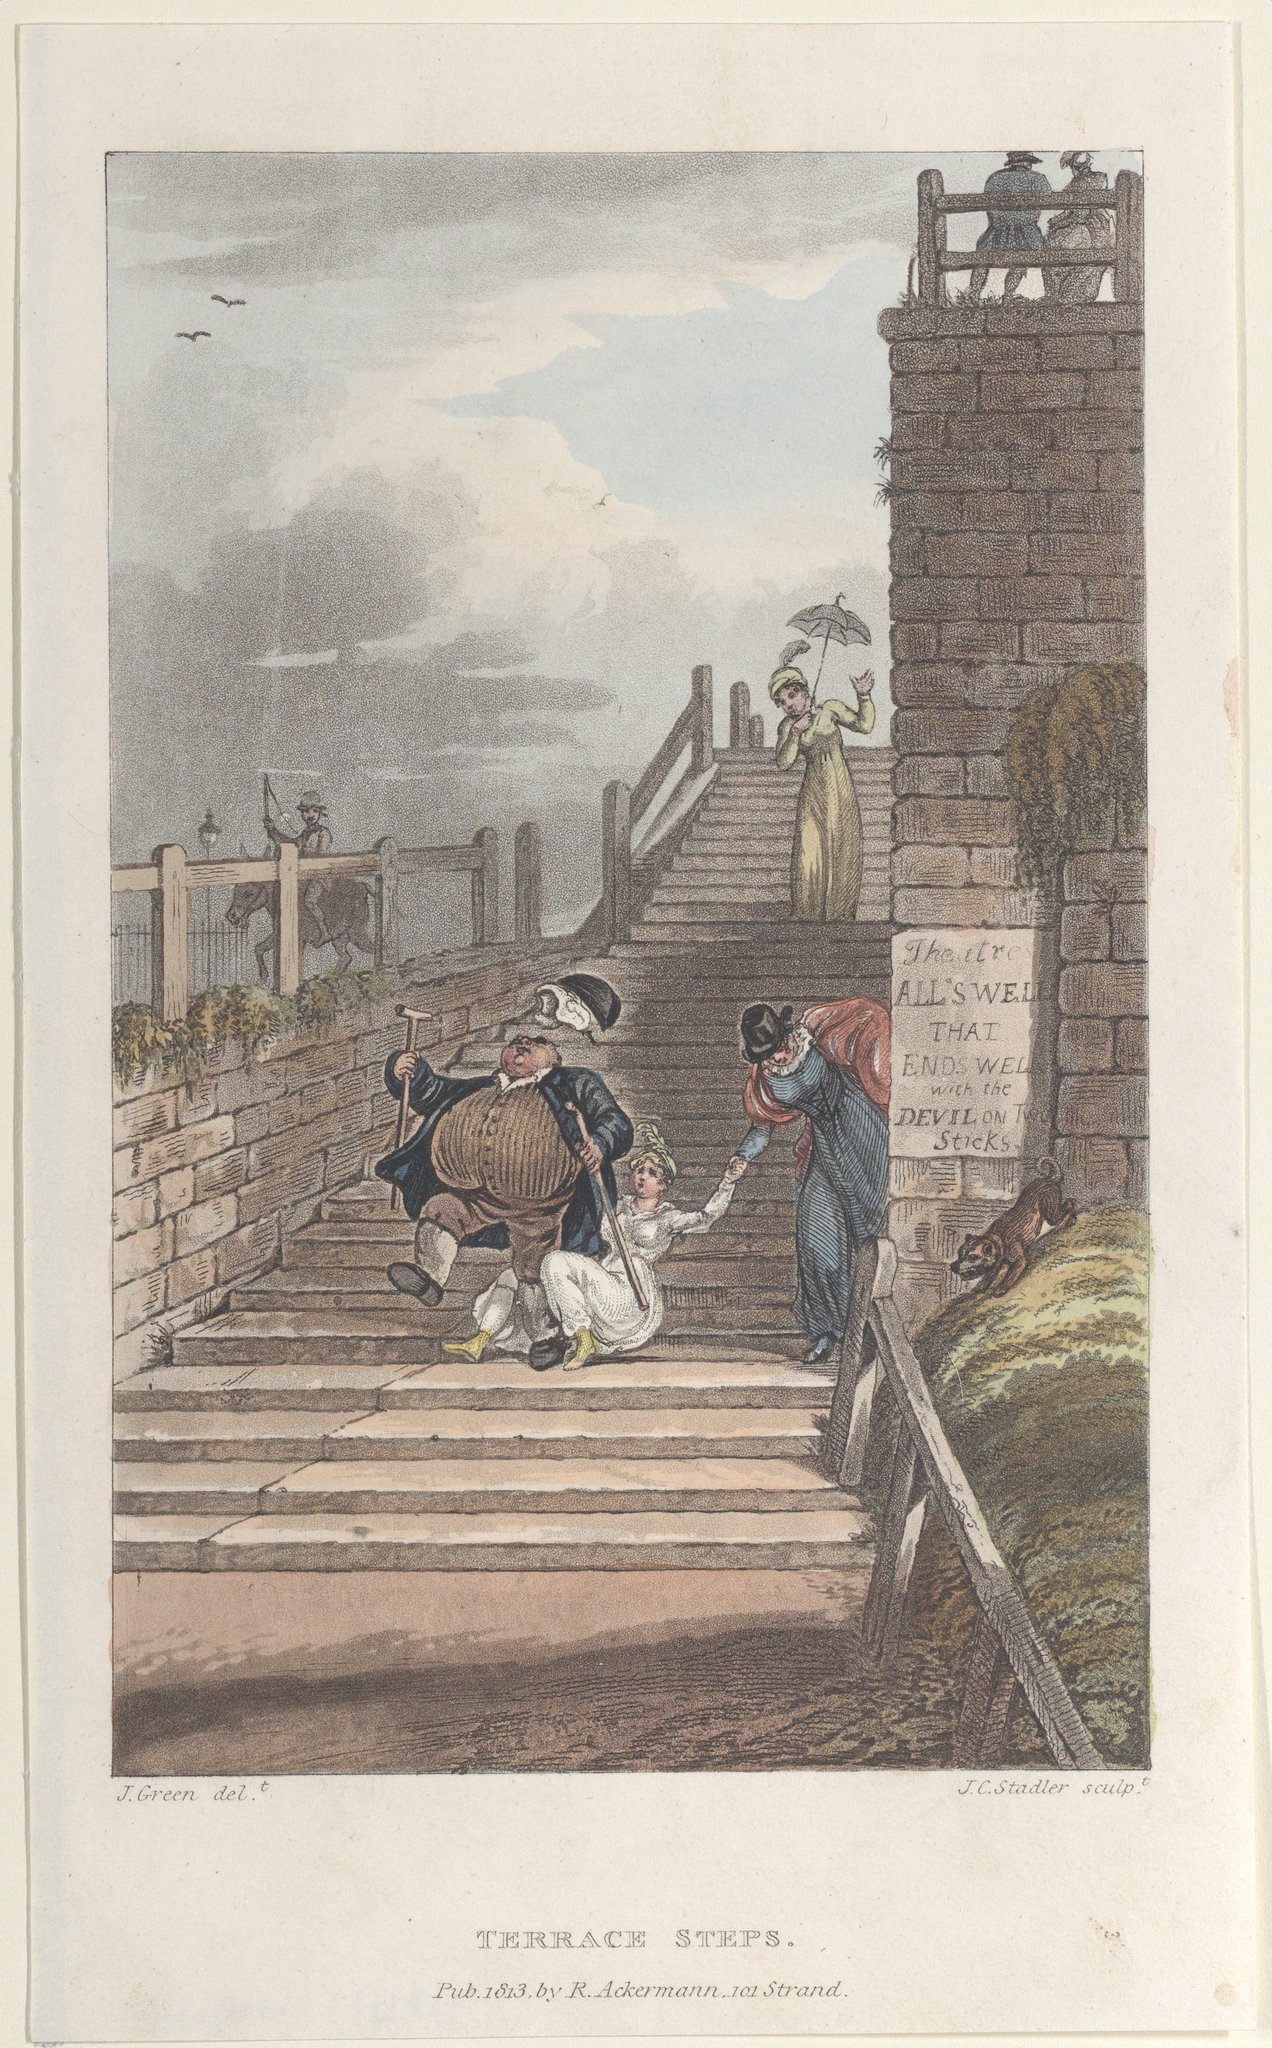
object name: print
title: Terrace Steps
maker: thomas rowlandson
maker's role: artist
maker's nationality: british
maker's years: 1757-1827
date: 1813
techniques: aquatint, etching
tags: satire,stairs,men,women